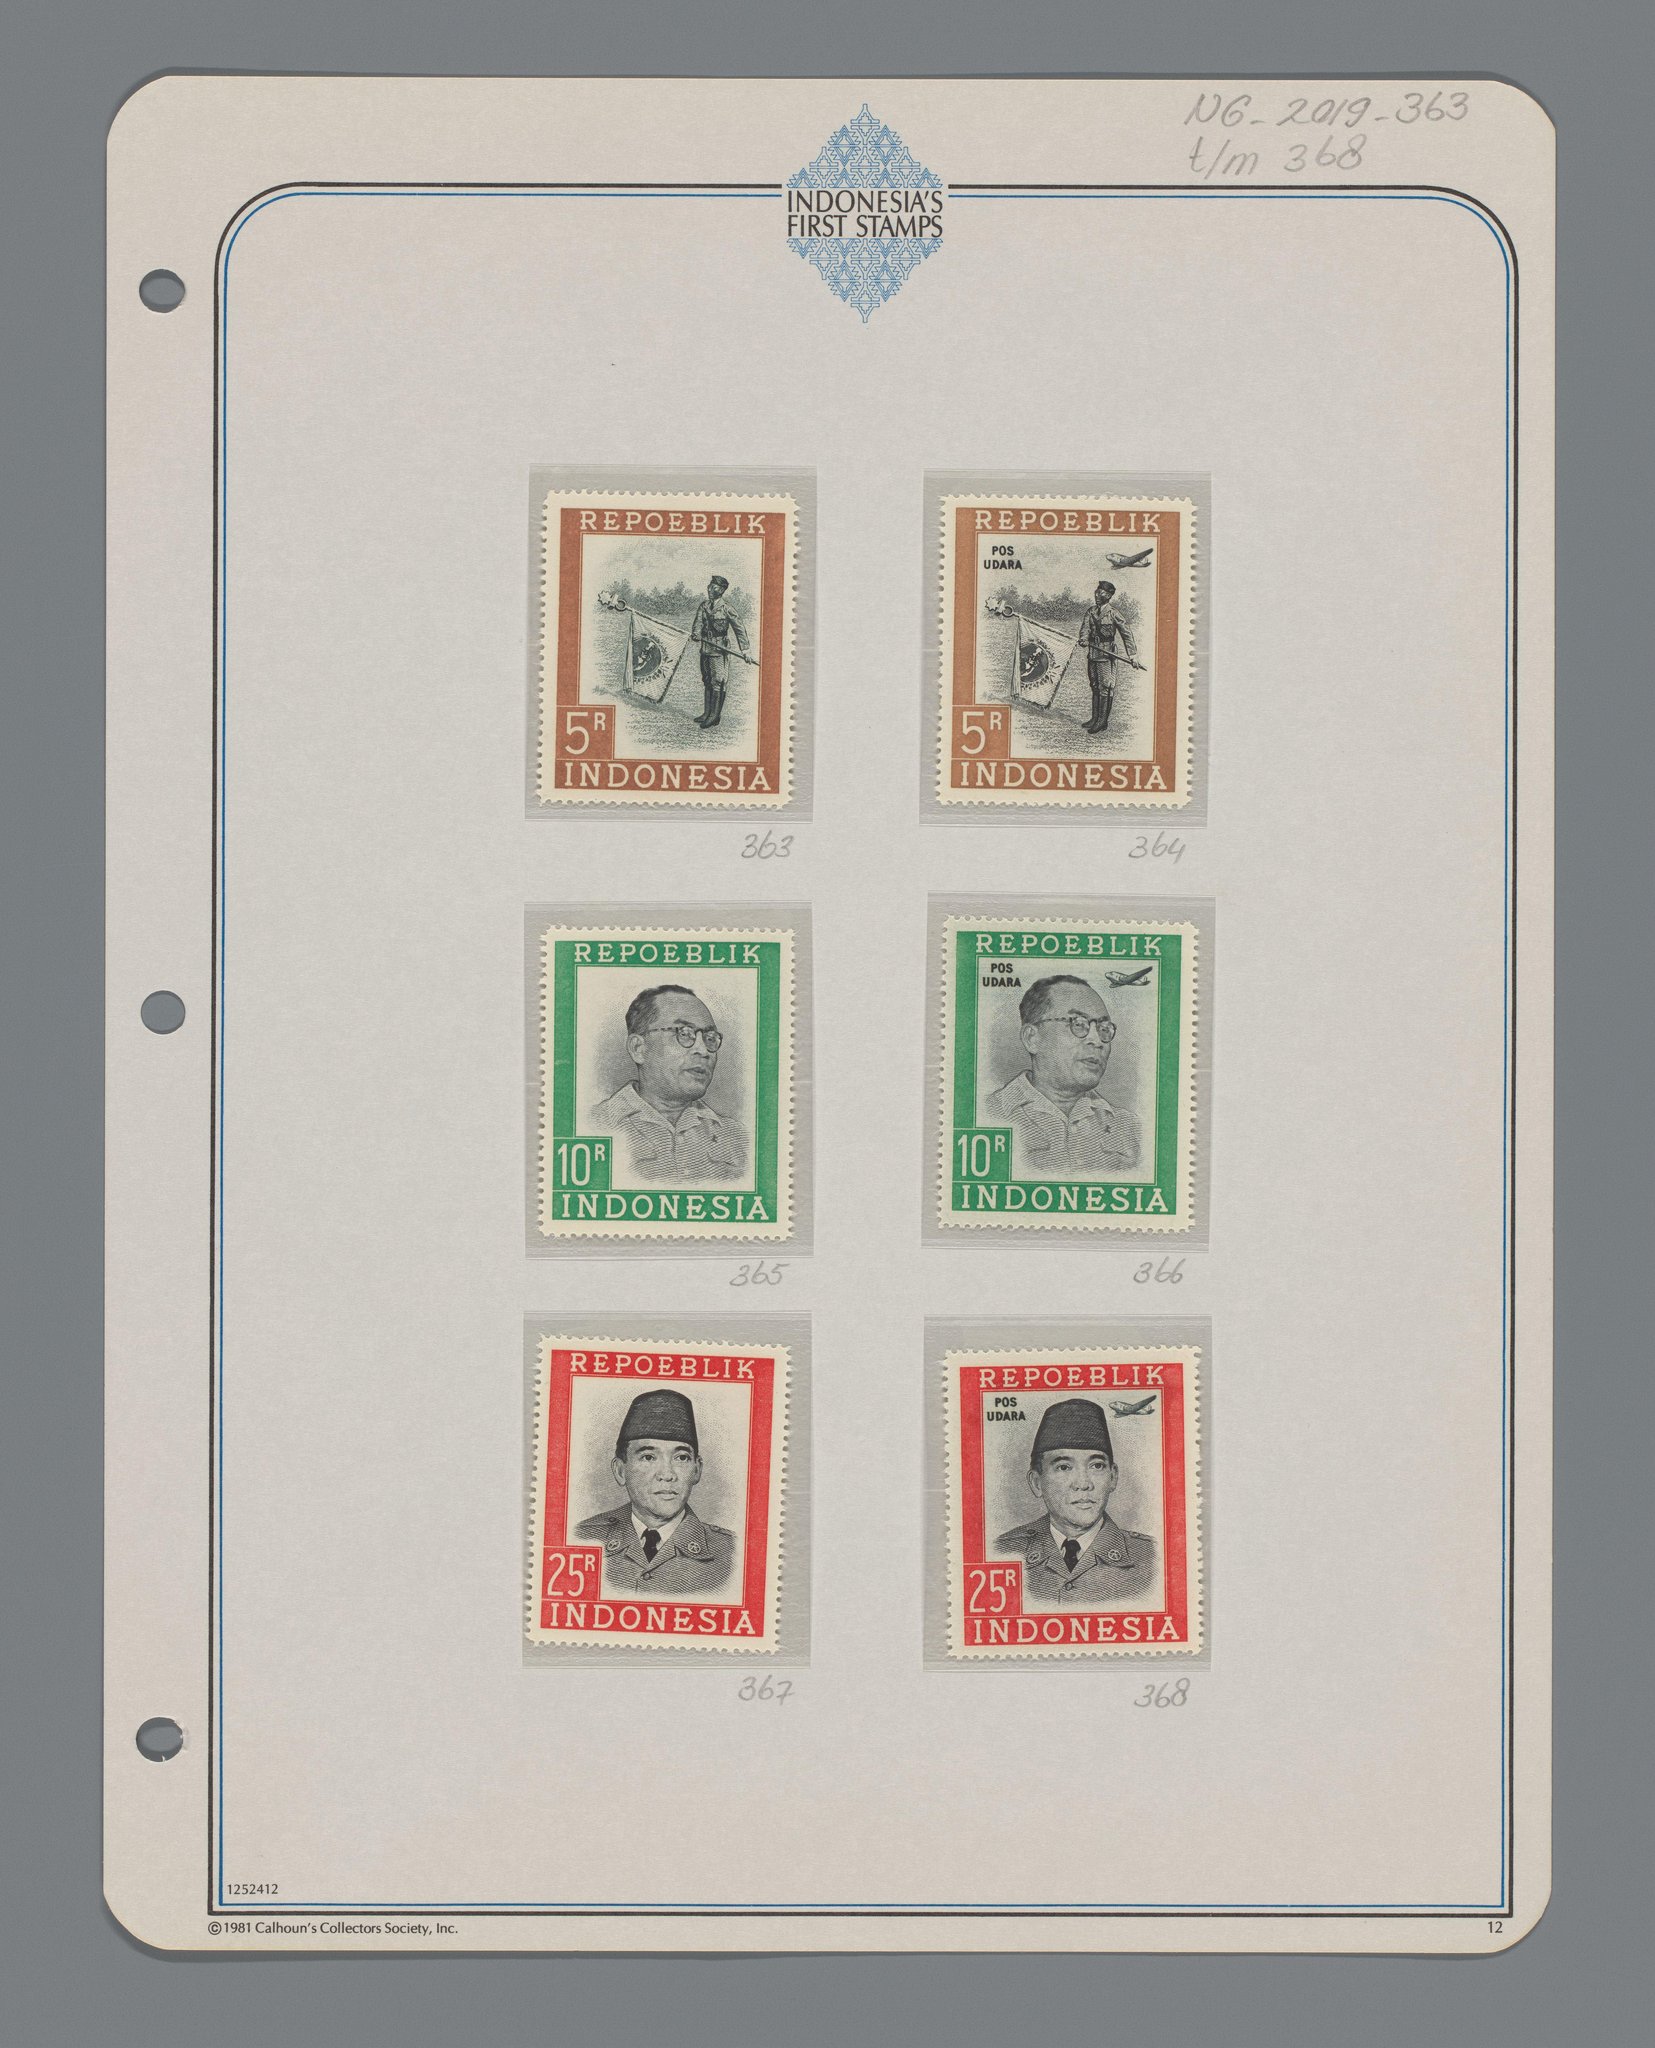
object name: postage stamp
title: Postzegel Republik Indonesia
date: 1949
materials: paper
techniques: photoaquatint, engraving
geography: philadelphia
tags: indonesia